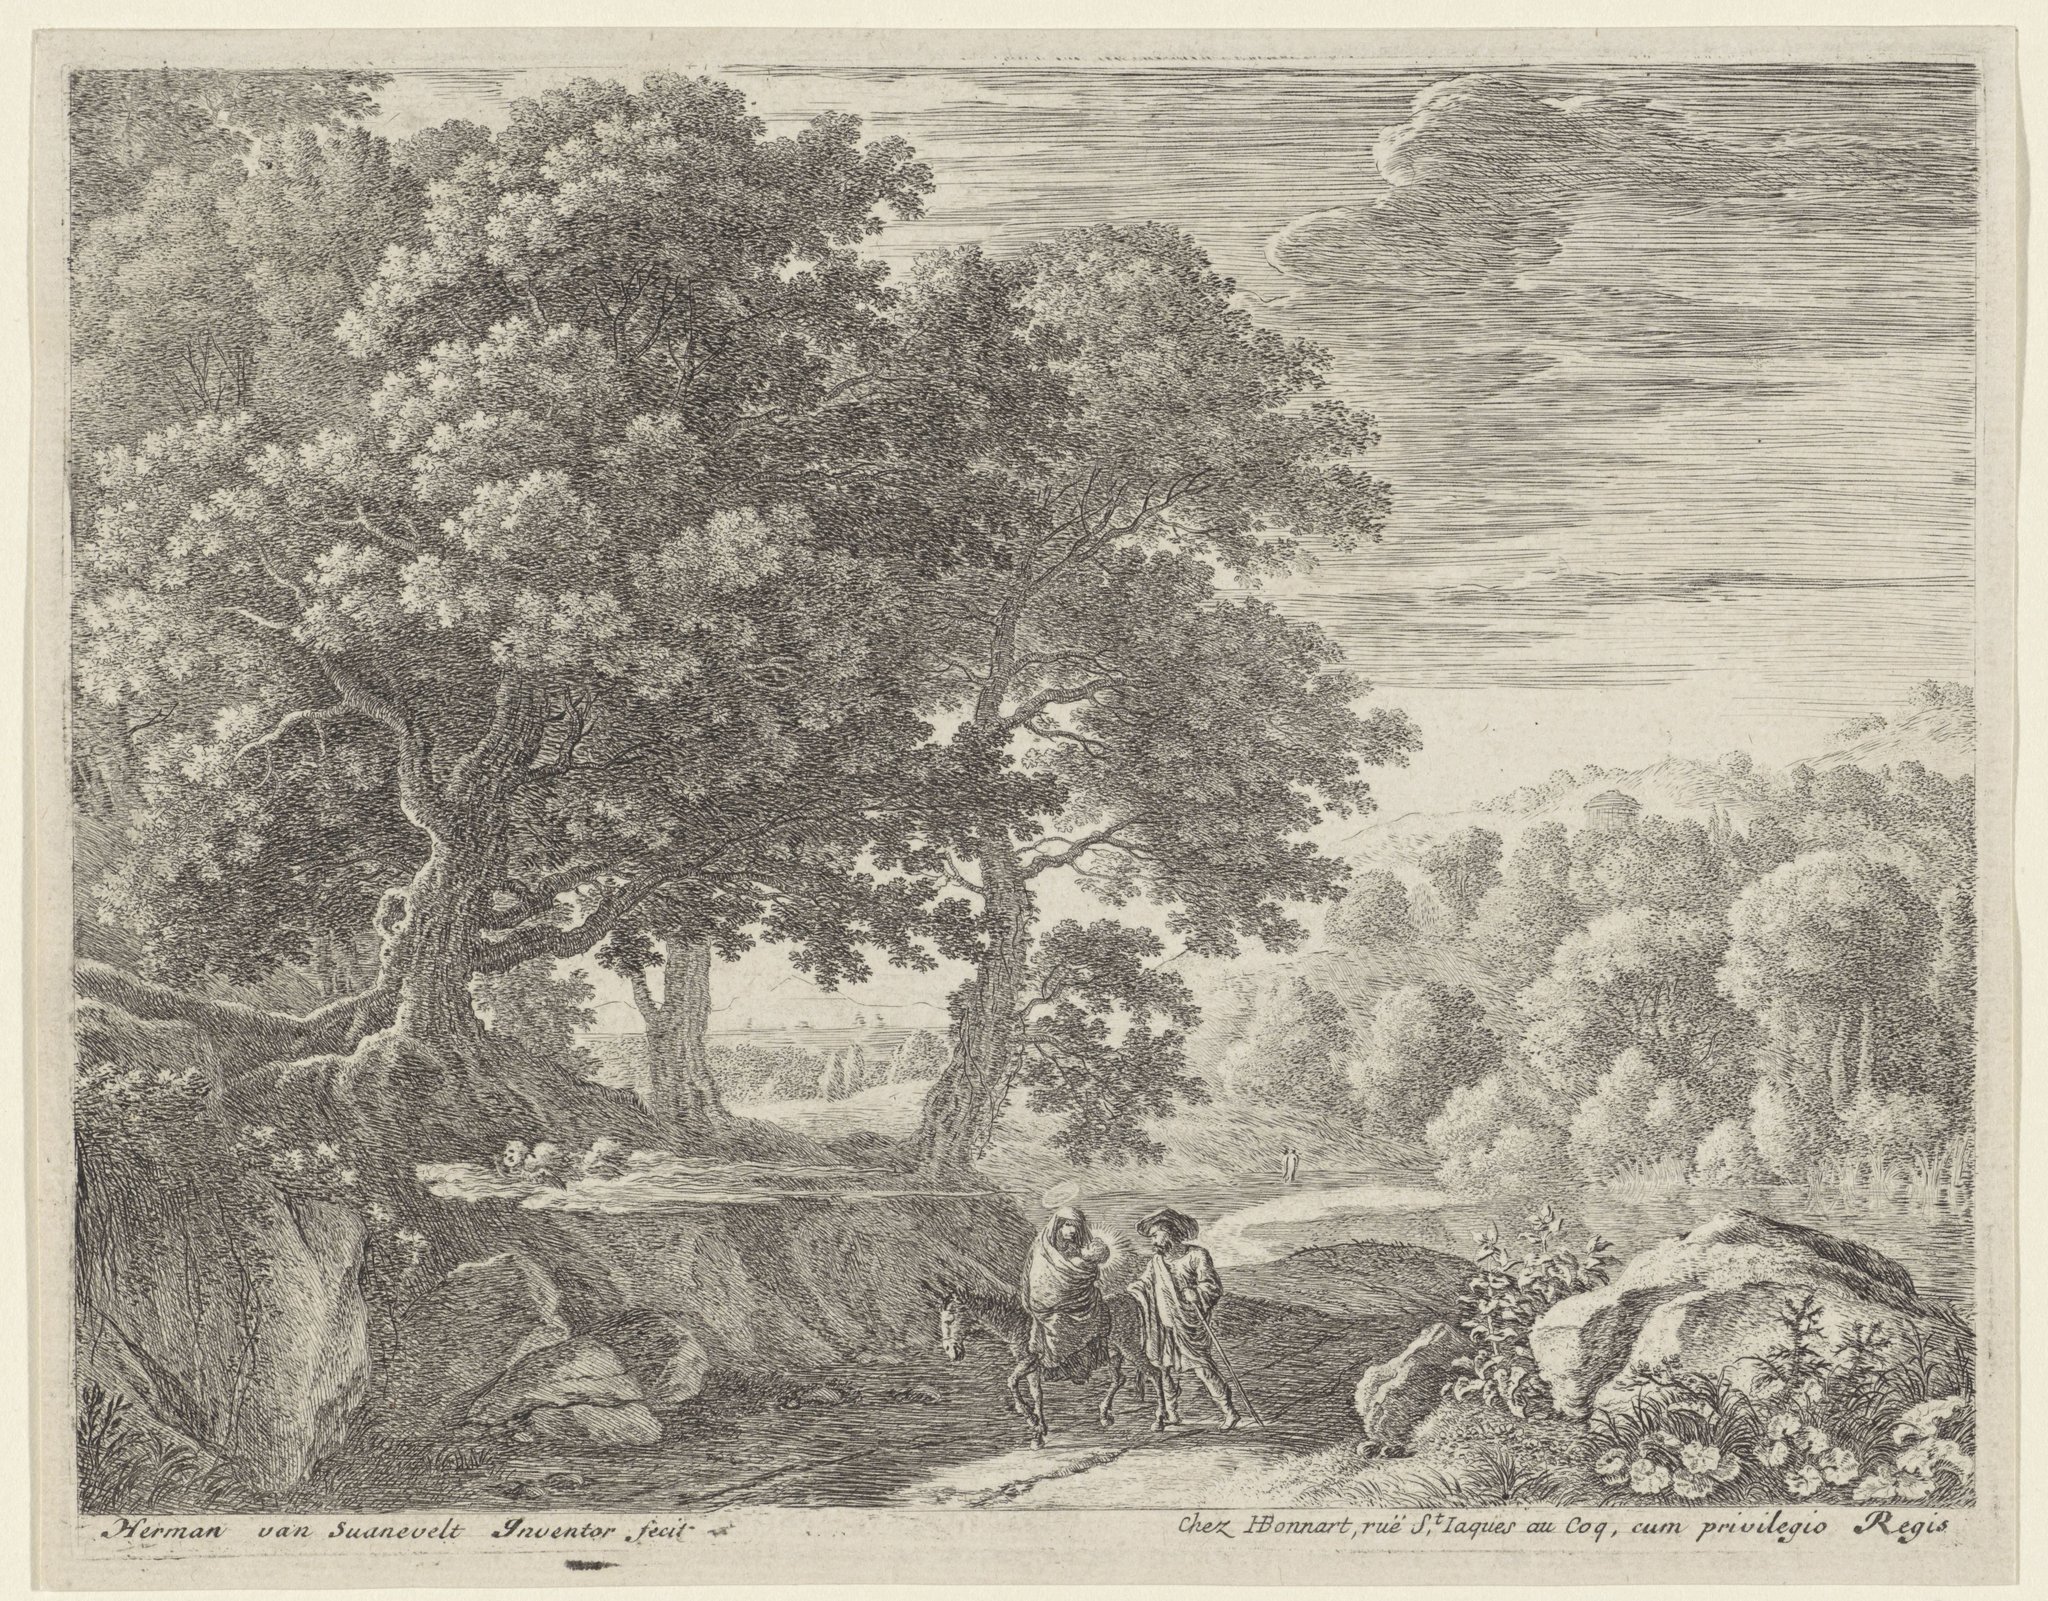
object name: print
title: Heilige familie met ezel en cherubijnen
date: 1643-1655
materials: paper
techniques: etching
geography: paris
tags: the flight into egypt: mary, joseph, the child (and sometimes others) on their way; mary usually riding on an ass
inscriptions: collector's mark: Lugt 2228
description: Er is een landschap met boompartijen en een waterpartij weergegeven. Op de voorgrond zit Maria met Christus in haar armen op een ezel. Jozef loopt achter de ezel en houdt een staf in zijn linkerhand. Op de linkerheuvel zijn drie cherubijnen te zien en op de rechterheuvel staat een ronde tempel.